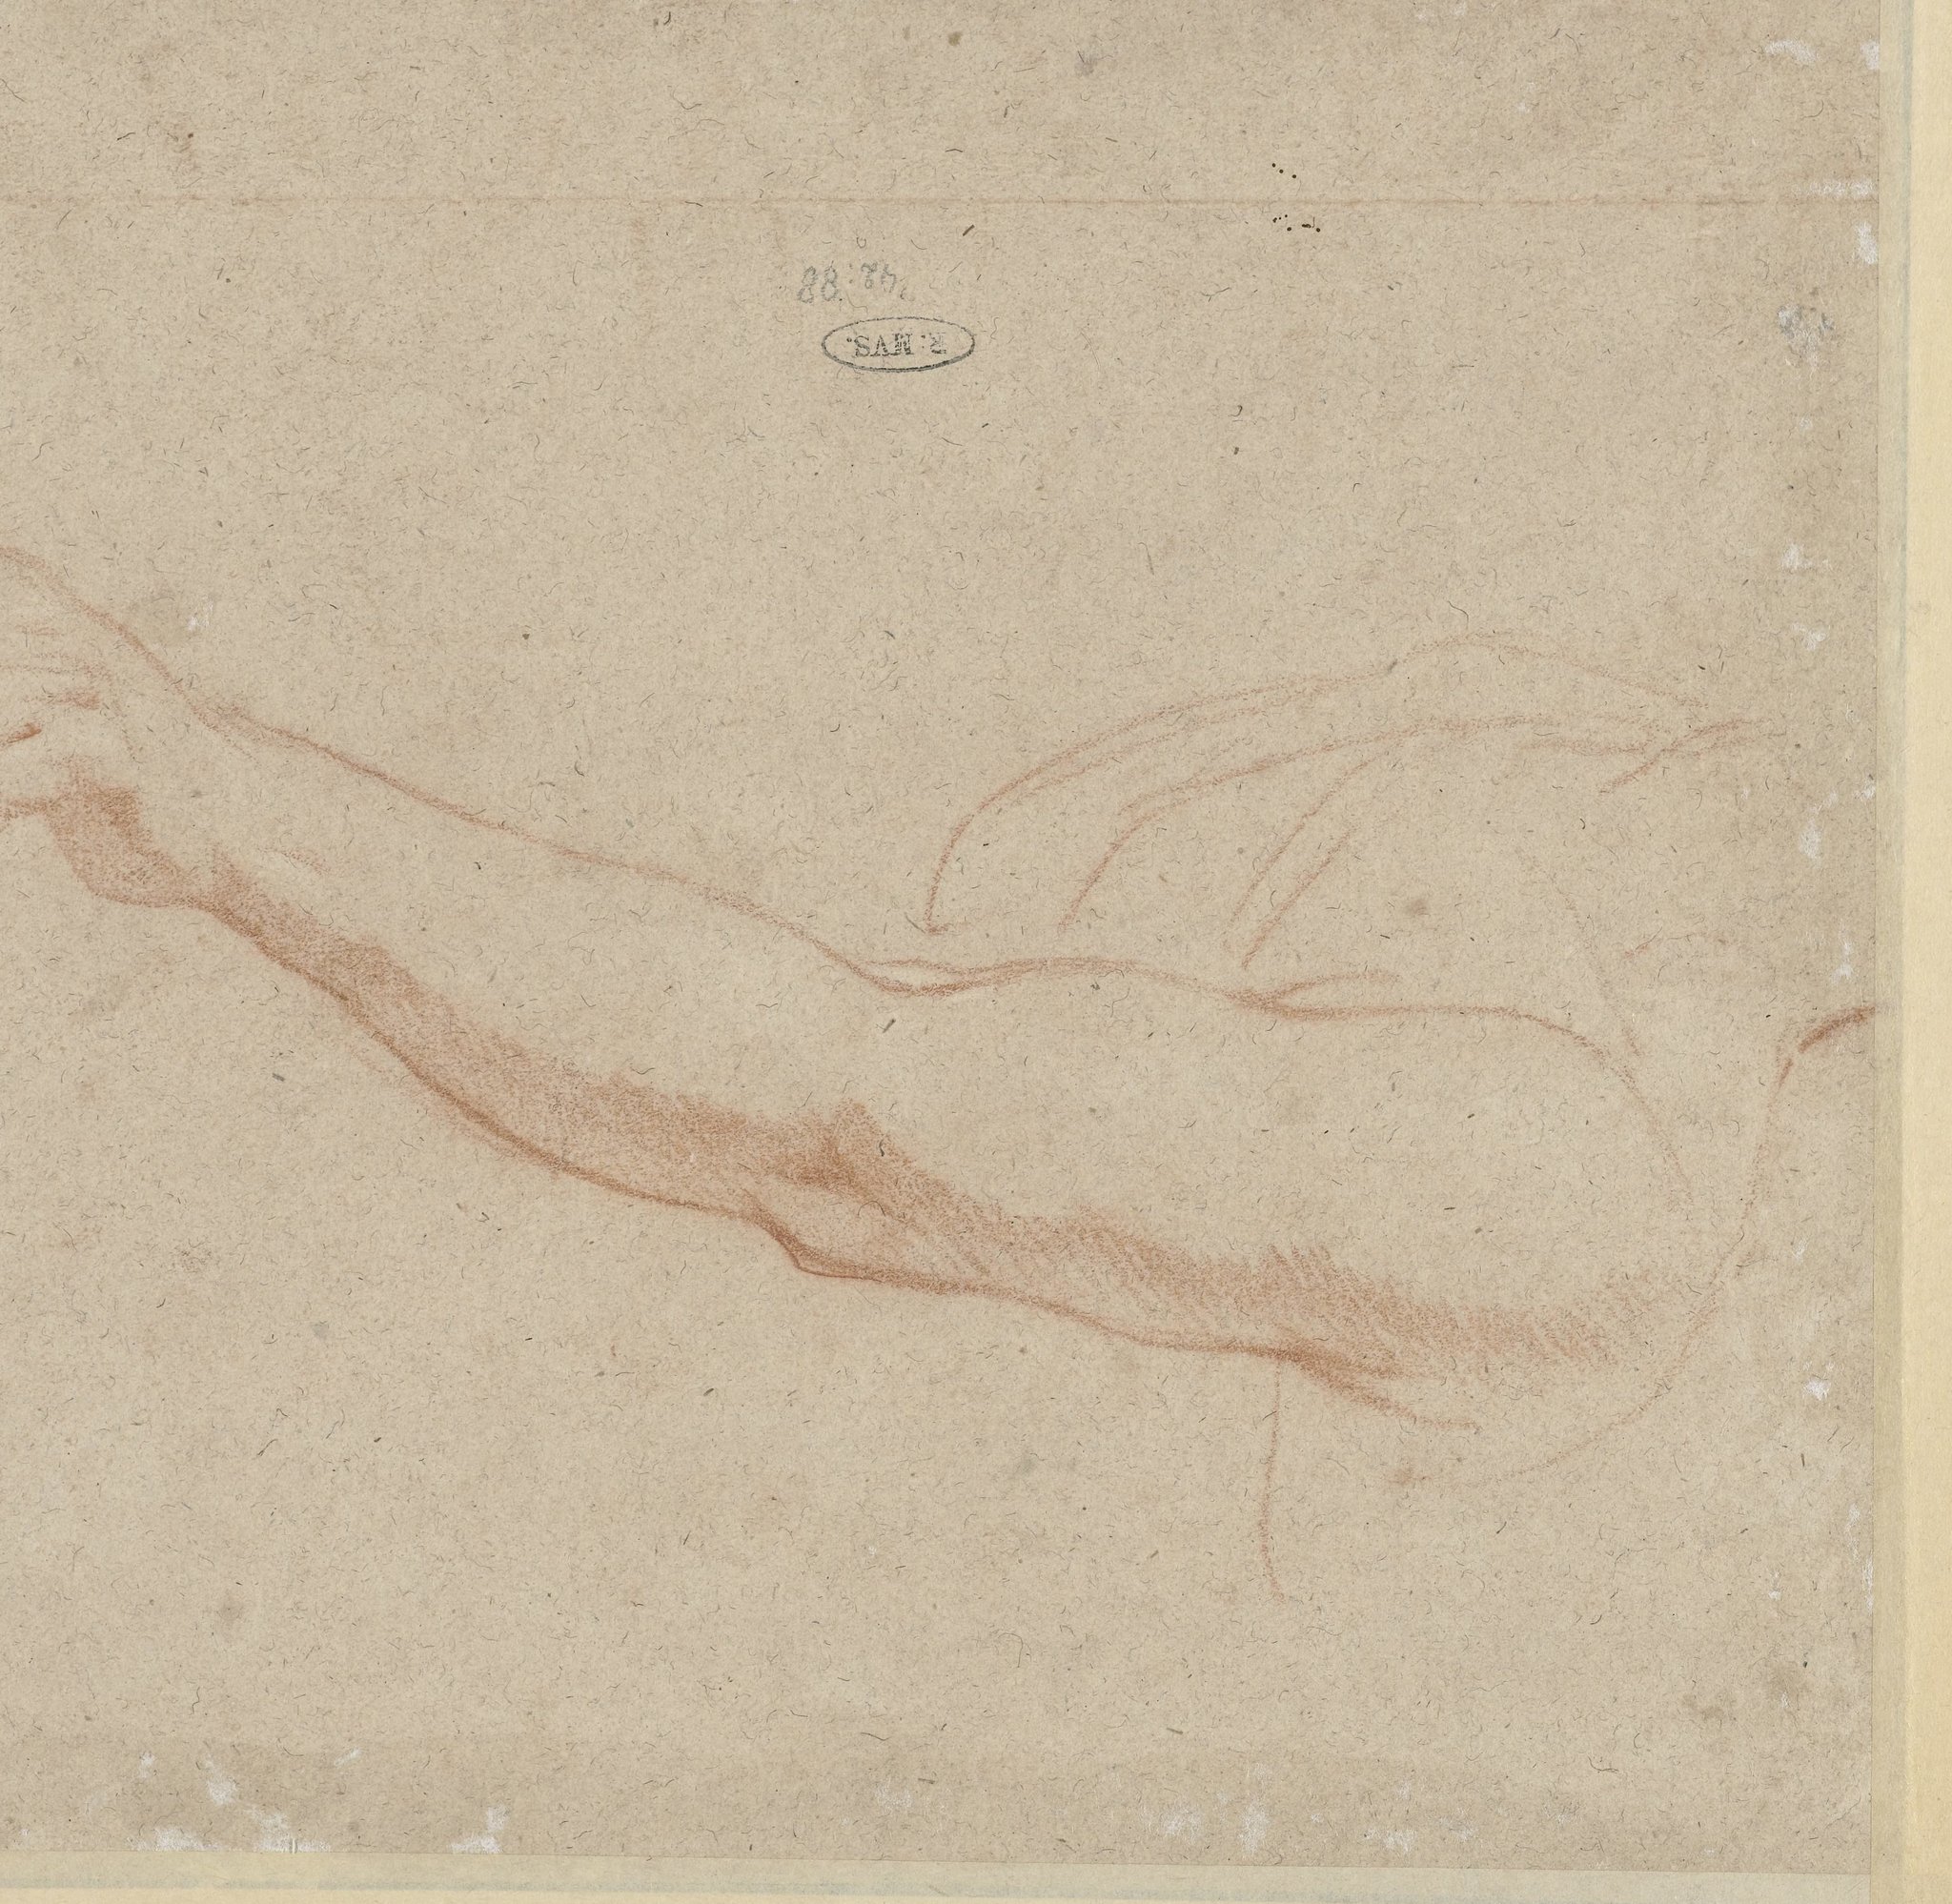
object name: drawing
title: Studie van een arm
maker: Anonymous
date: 1600-1699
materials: chalk, paper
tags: postures and gestures of arms and hands, arm stretched forward